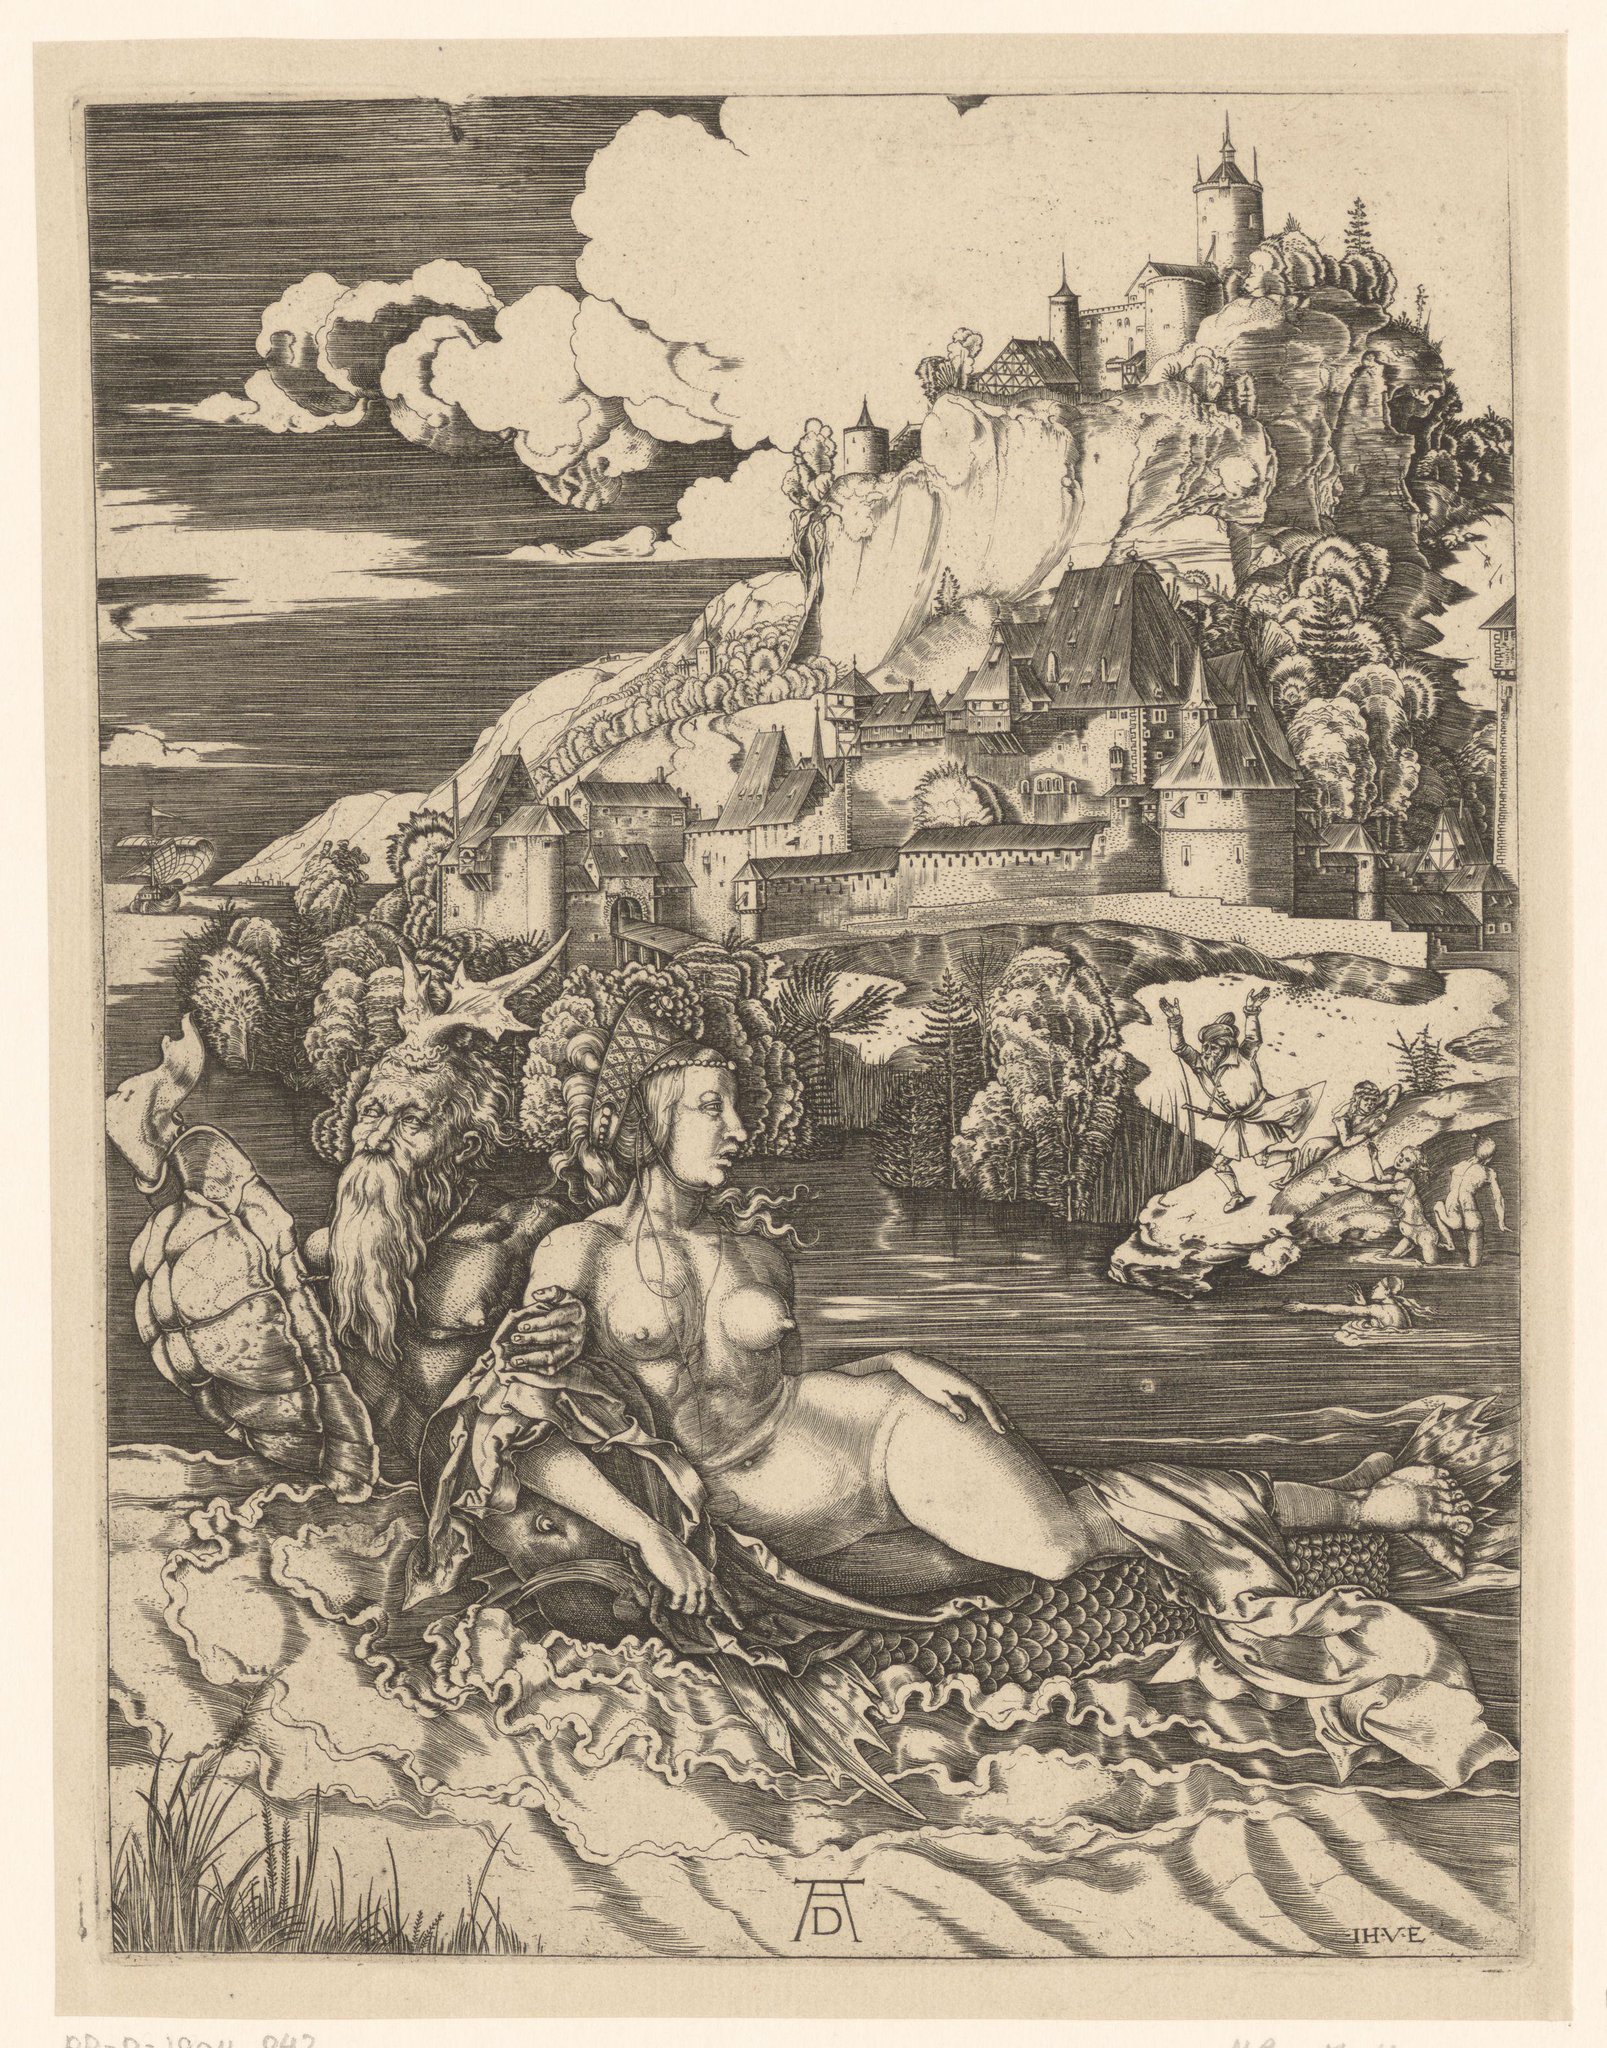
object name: print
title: Gehoornde meerman trekt een vrouw de zee in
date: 1522-1561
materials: paper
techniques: engraving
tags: triton(s), merman, (story of) triton - aggressive, unfriendly activities and relationships, syme carried off by glaucus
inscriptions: collector's mark: Lugt 2228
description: Deze prent is een gespiegelde versie van het origineel ontwerp door Albrecht Dürer uit 1498-1500 en was getiteld 'Das Meerwunder'. De prent wordt onder andere geïnterpreteerd als de verkrachting van Amymone door Triton, de ontvoering van Syme door Glaucus, en het ontsnappen van Aeneas door Anna Perenna met behulp van een meerman.